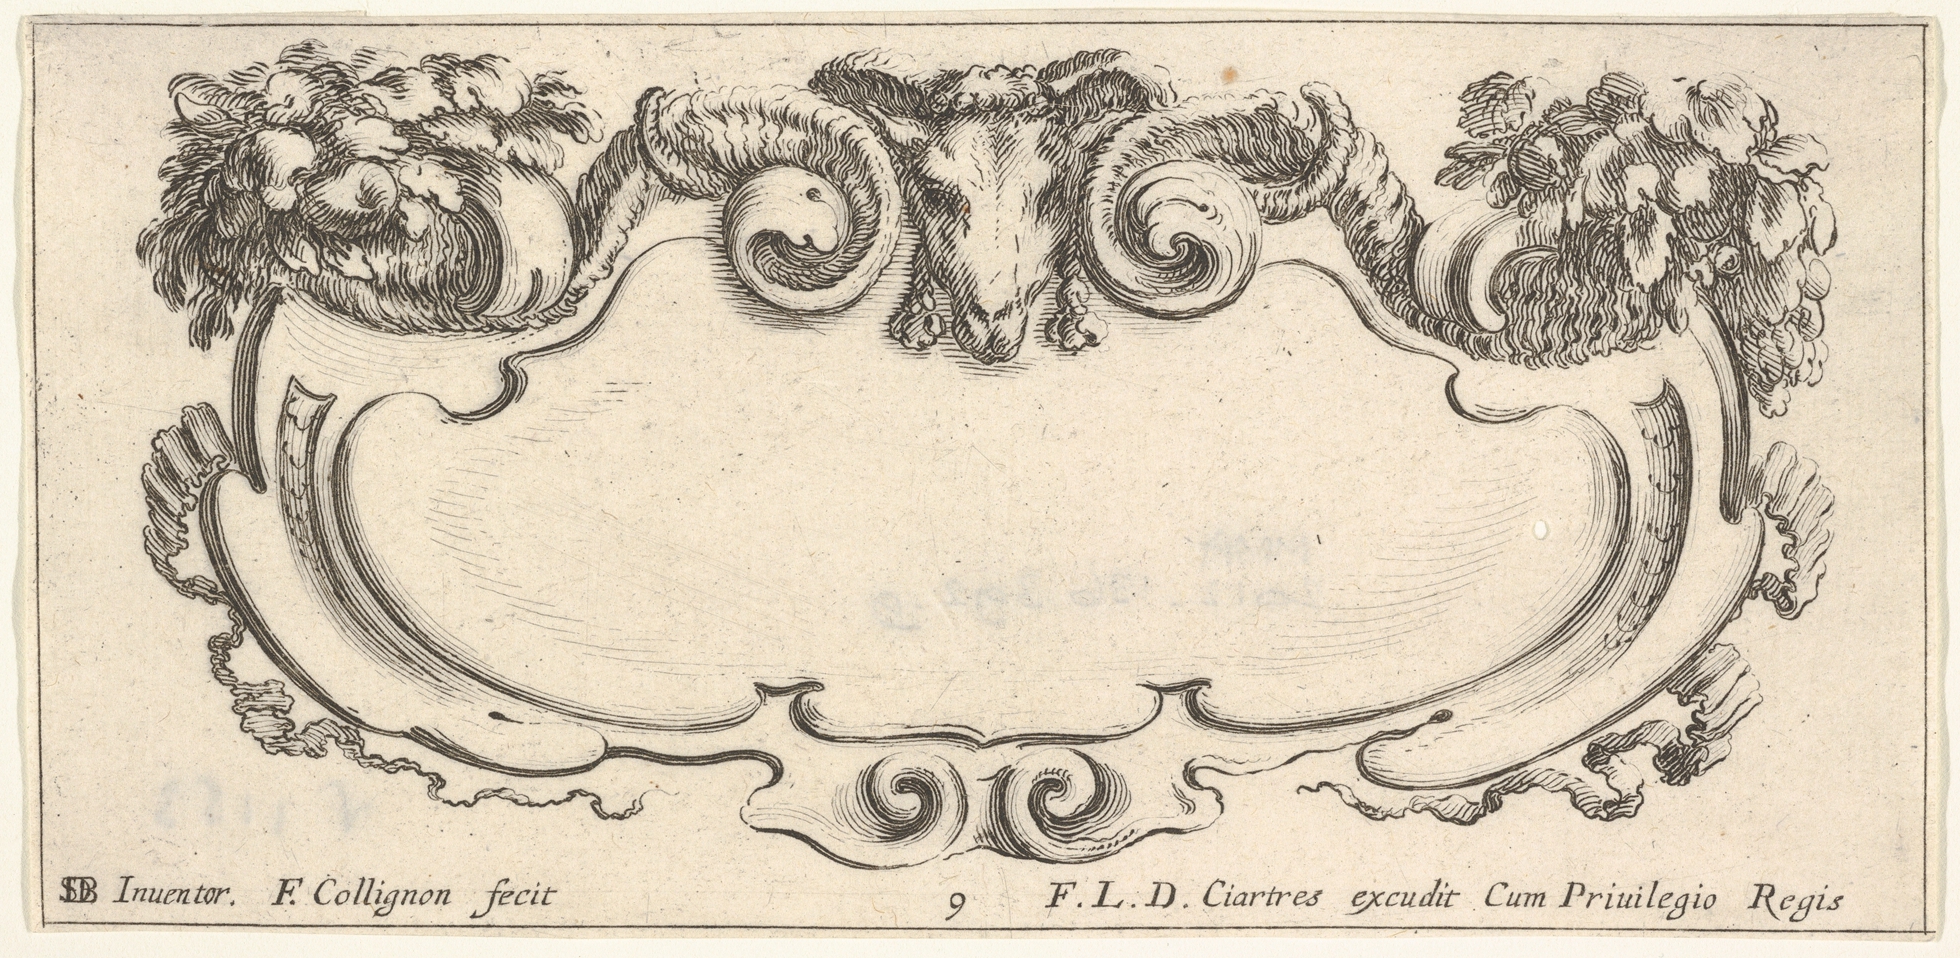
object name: print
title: Plate 9: a cartouche with the head of a ram at top center, flowers at top left and right, from "Twelve cartouches" (Recueil de douze cartouches)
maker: françois collignon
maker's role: artist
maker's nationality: french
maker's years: 1605-1687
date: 1640-1645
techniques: etching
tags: cartouches,rams,flowers